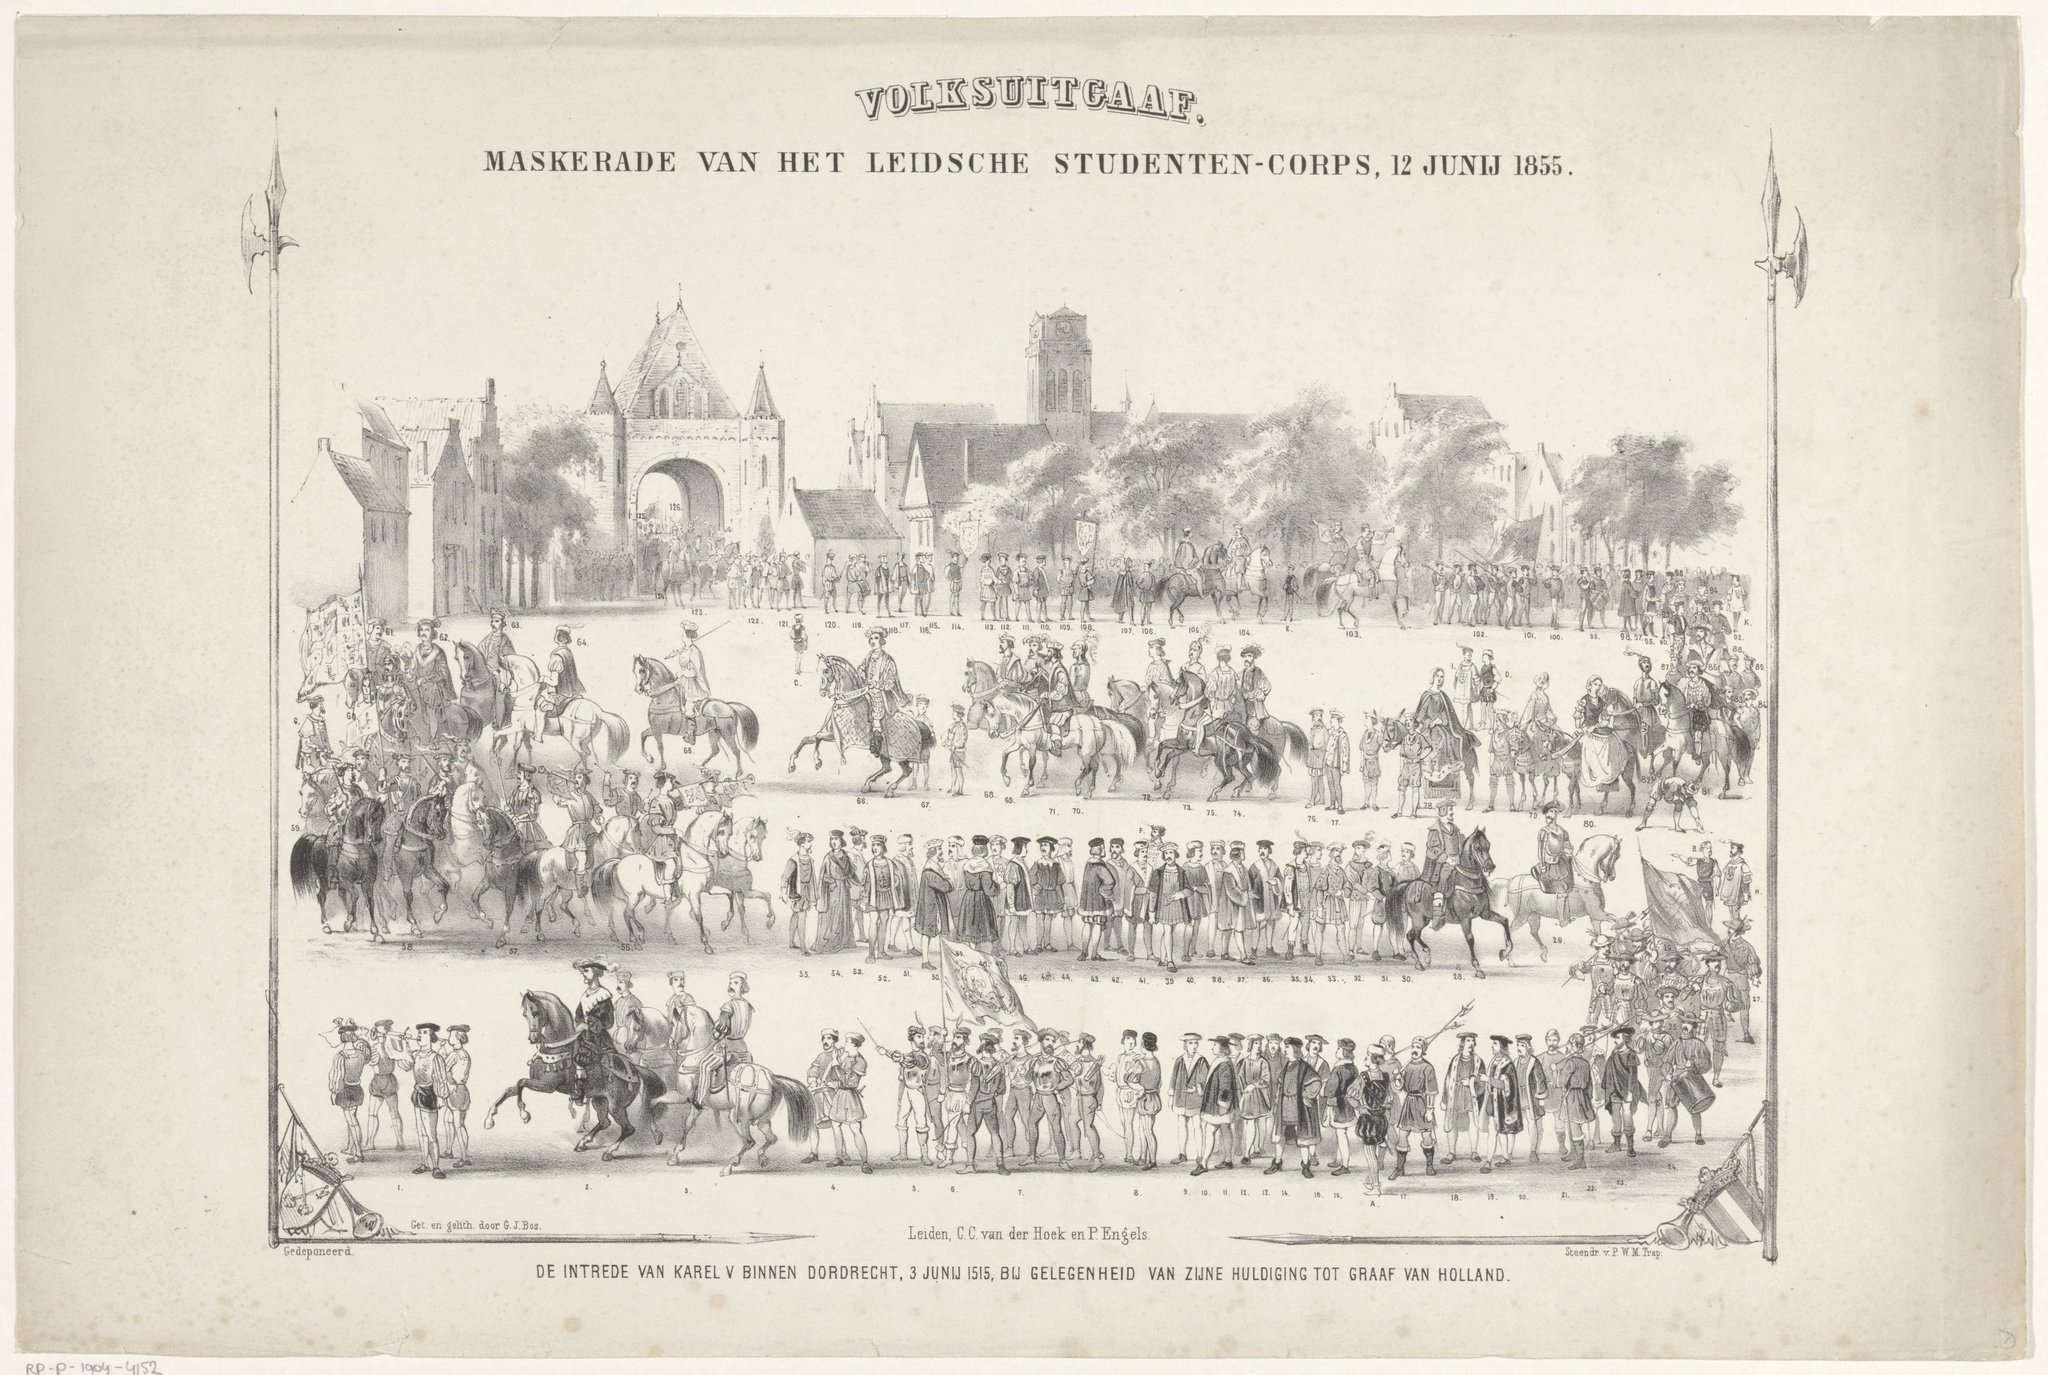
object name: print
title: Leidse maskerade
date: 1835-1898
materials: paper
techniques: lithograph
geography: netherlands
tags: ghent, charles v (holy roman emperor and king of spain), students' pageant, masquerade, masked ball, leiden, dordrecht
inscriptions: : ‘Gedeponeerd.’, collector's mark: Lugt 2228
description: Studenten spelen de intocht van Karel V in Dordrecht op 13 juni 1515 na. De optocht bestaat vooral uit edelmannen te voet en te paard. Enkelen van hen dragen een vaandel. In de achtergrond een stadspoort en een kerk.